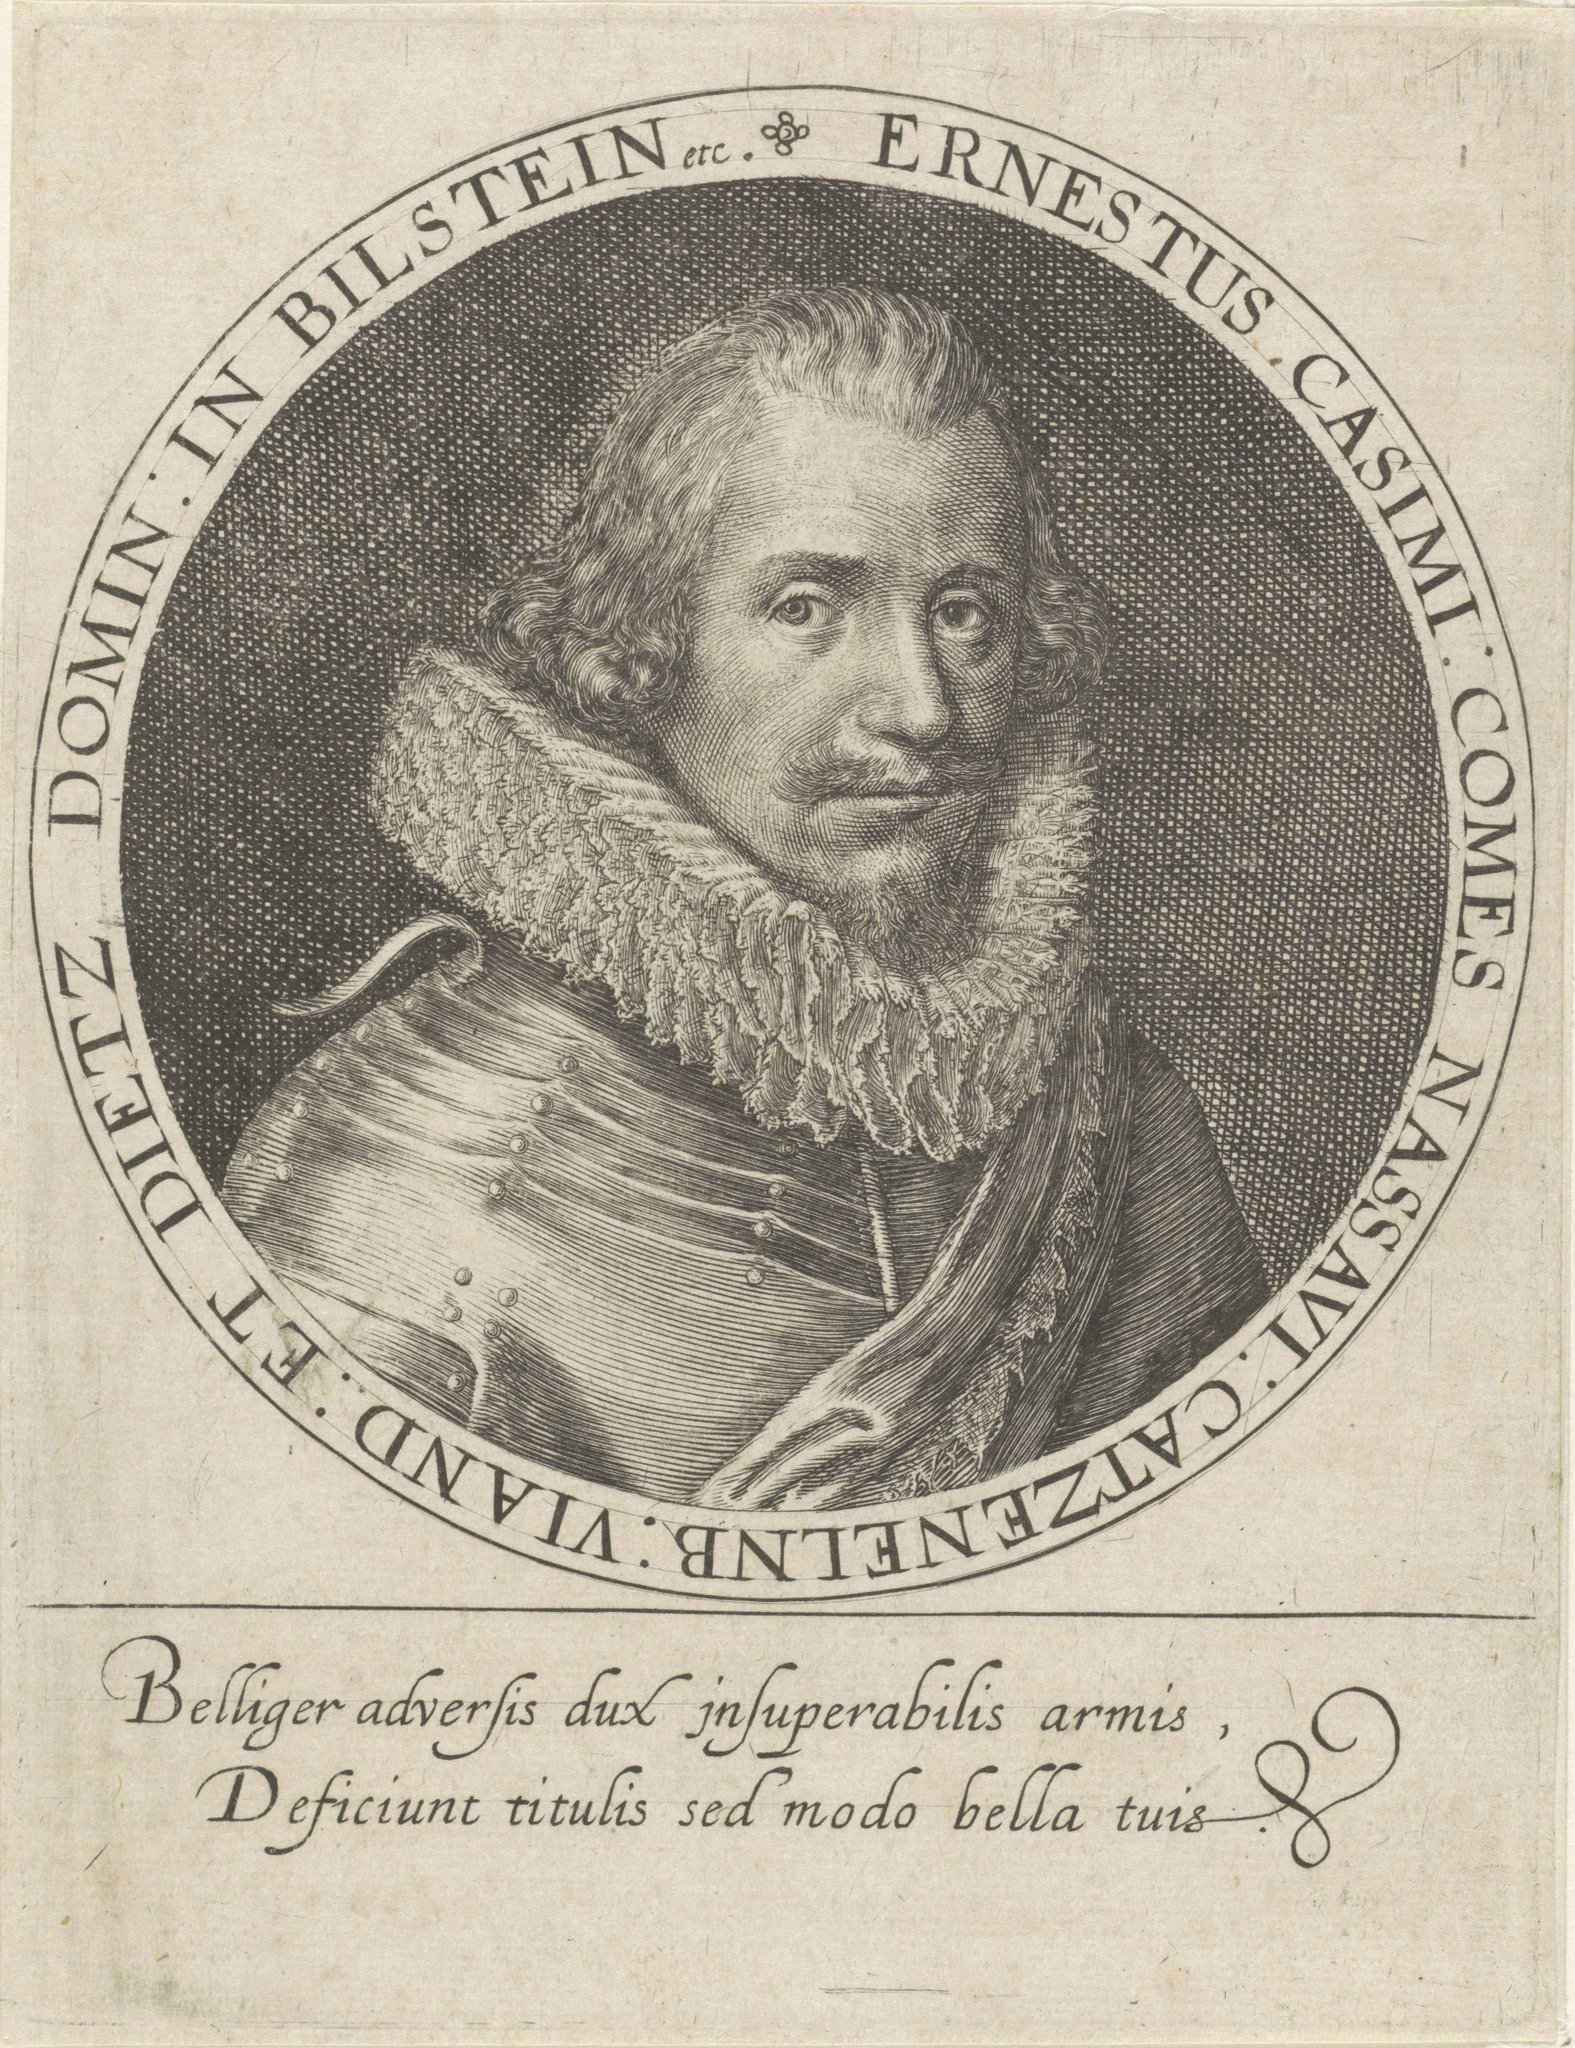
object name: book illustration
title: Portret van Ernst Casimir, graaf van Nassau-Dietz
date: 1615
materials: paper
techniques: engraving, etching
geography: utrecht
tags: ernst casimir graaf van nassau-dietz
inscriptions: collector's mark: Lugt 2228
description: De hier vermelde titel verwijst naar de hoogst verkregen titel van de geportretteerde, niet per se naar de titel die de geportretteerde op deze voorstelling draagt. Prent uit: Buchelius, Arnoldus. Nassovischen Oraignen-boom, daer by ghevoecht, de conterfeytsels der voornaemster helden. = Malus Aurantius Nassovicus. Utrecht: Salomon de Roy, 1615.